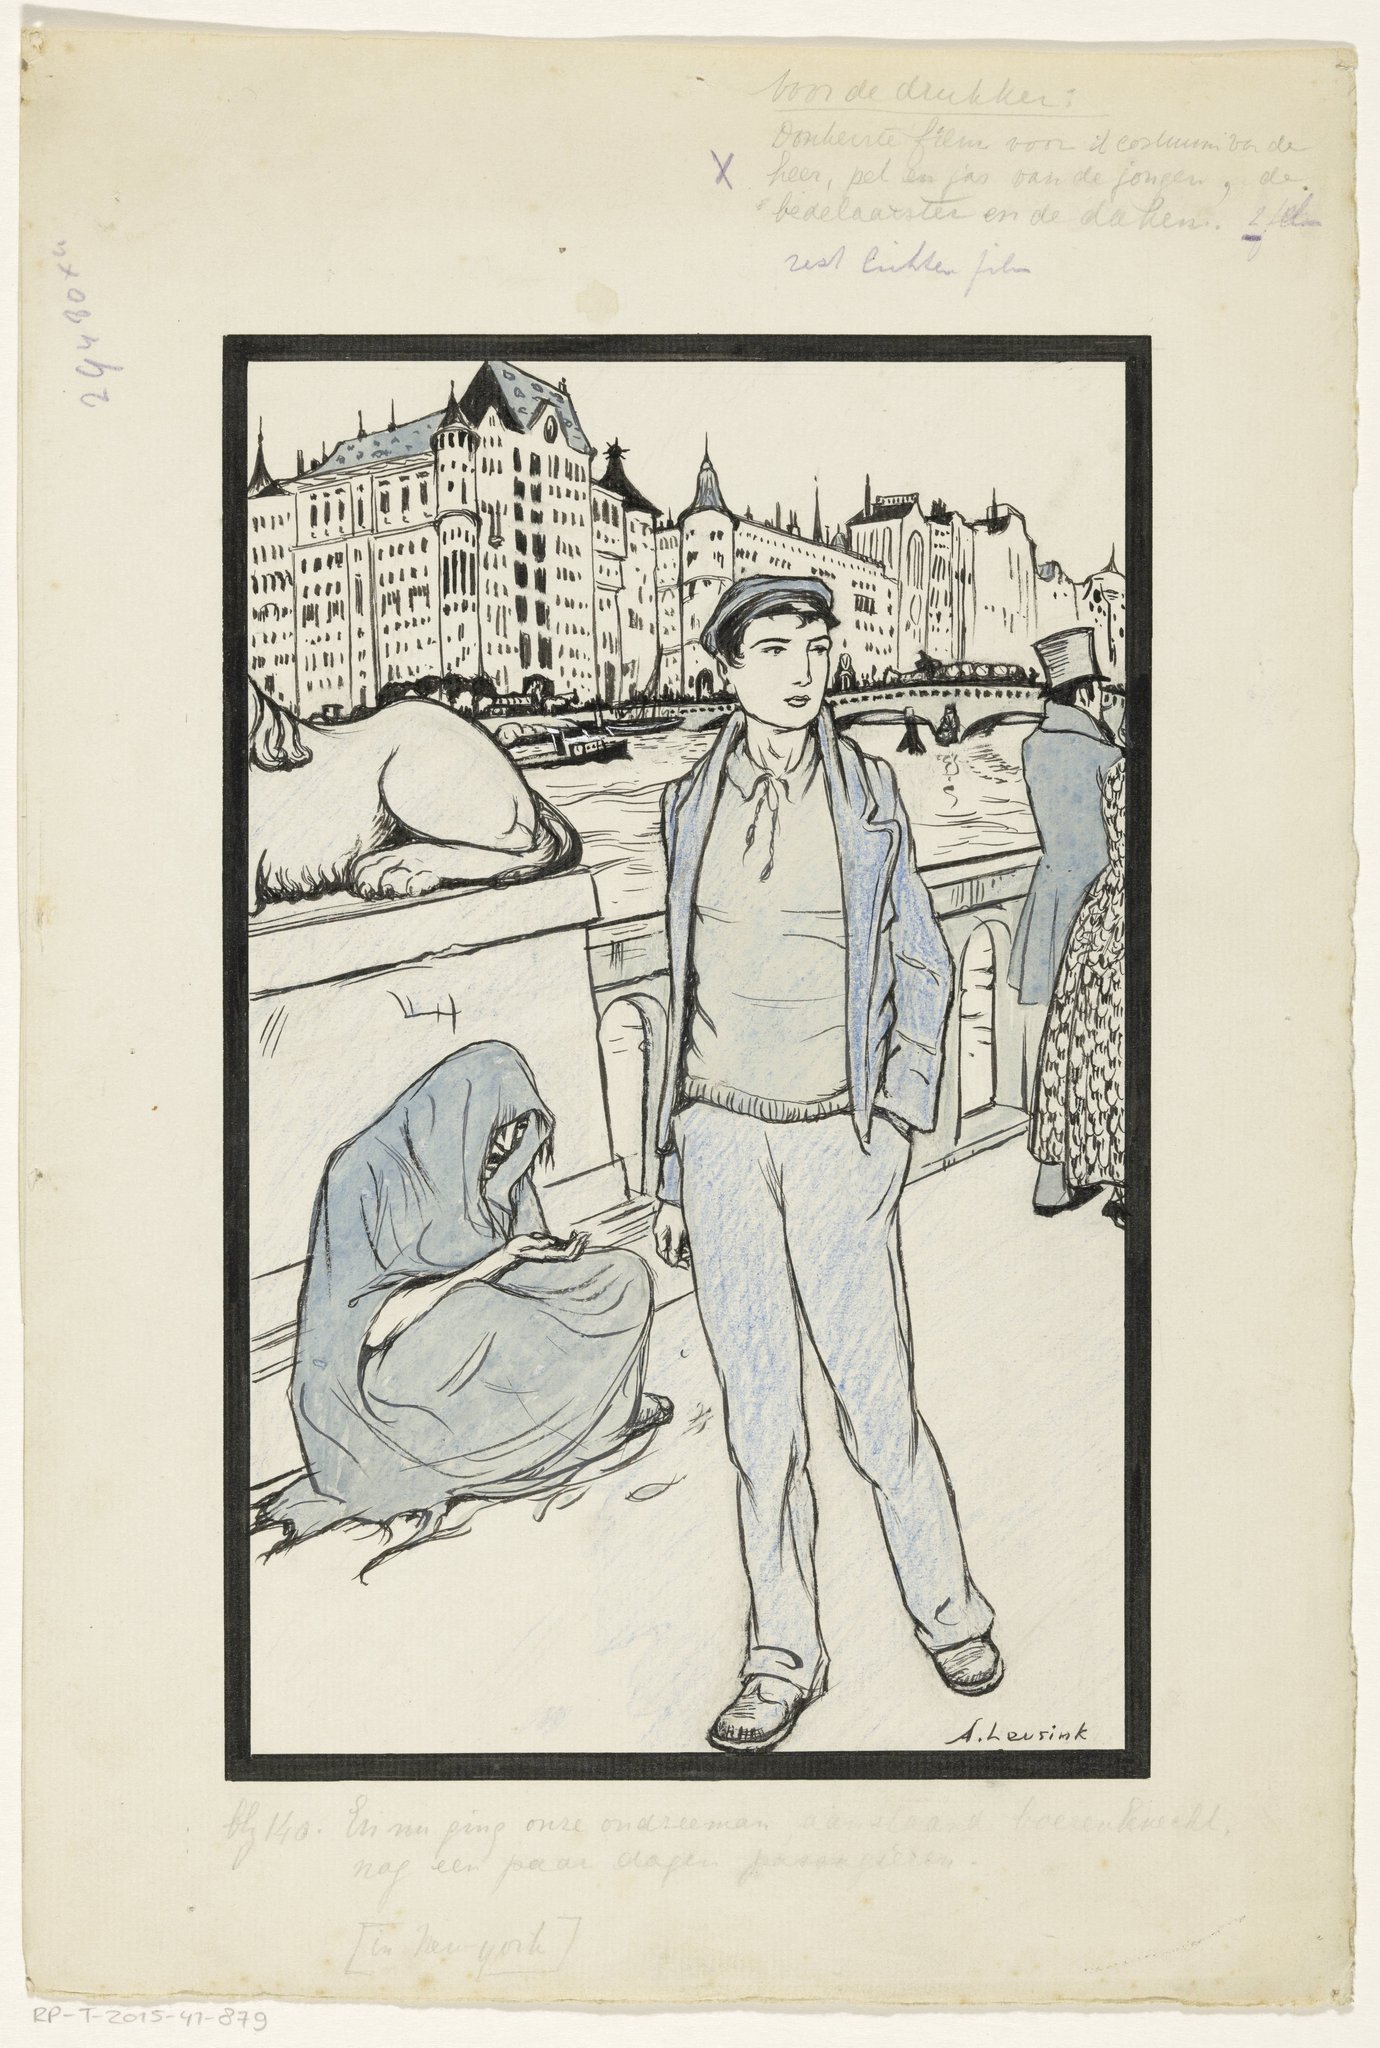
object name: boekillustratie ontwerp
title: Willem loopt over een brug in een stad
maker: anny leusink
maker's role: draughtsman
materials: paint, ink, paper, pencil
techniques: brush, pen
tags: youth, adolescent, canals, waters (in city), beggar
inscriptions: :, collector's mark: Lugt 2228, annotation: ‘blz 140. En nu ging onze oudzeeman, aanstaand boerenknecht,/ nog een paar dagen passagieren/ [in New York]’, signature: ‘A. Leusink’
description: Willem loopt over een brug voorbij een bedelende vrouw. Op de achtergrond zijn een brug en stedelijke architectuur te zien.